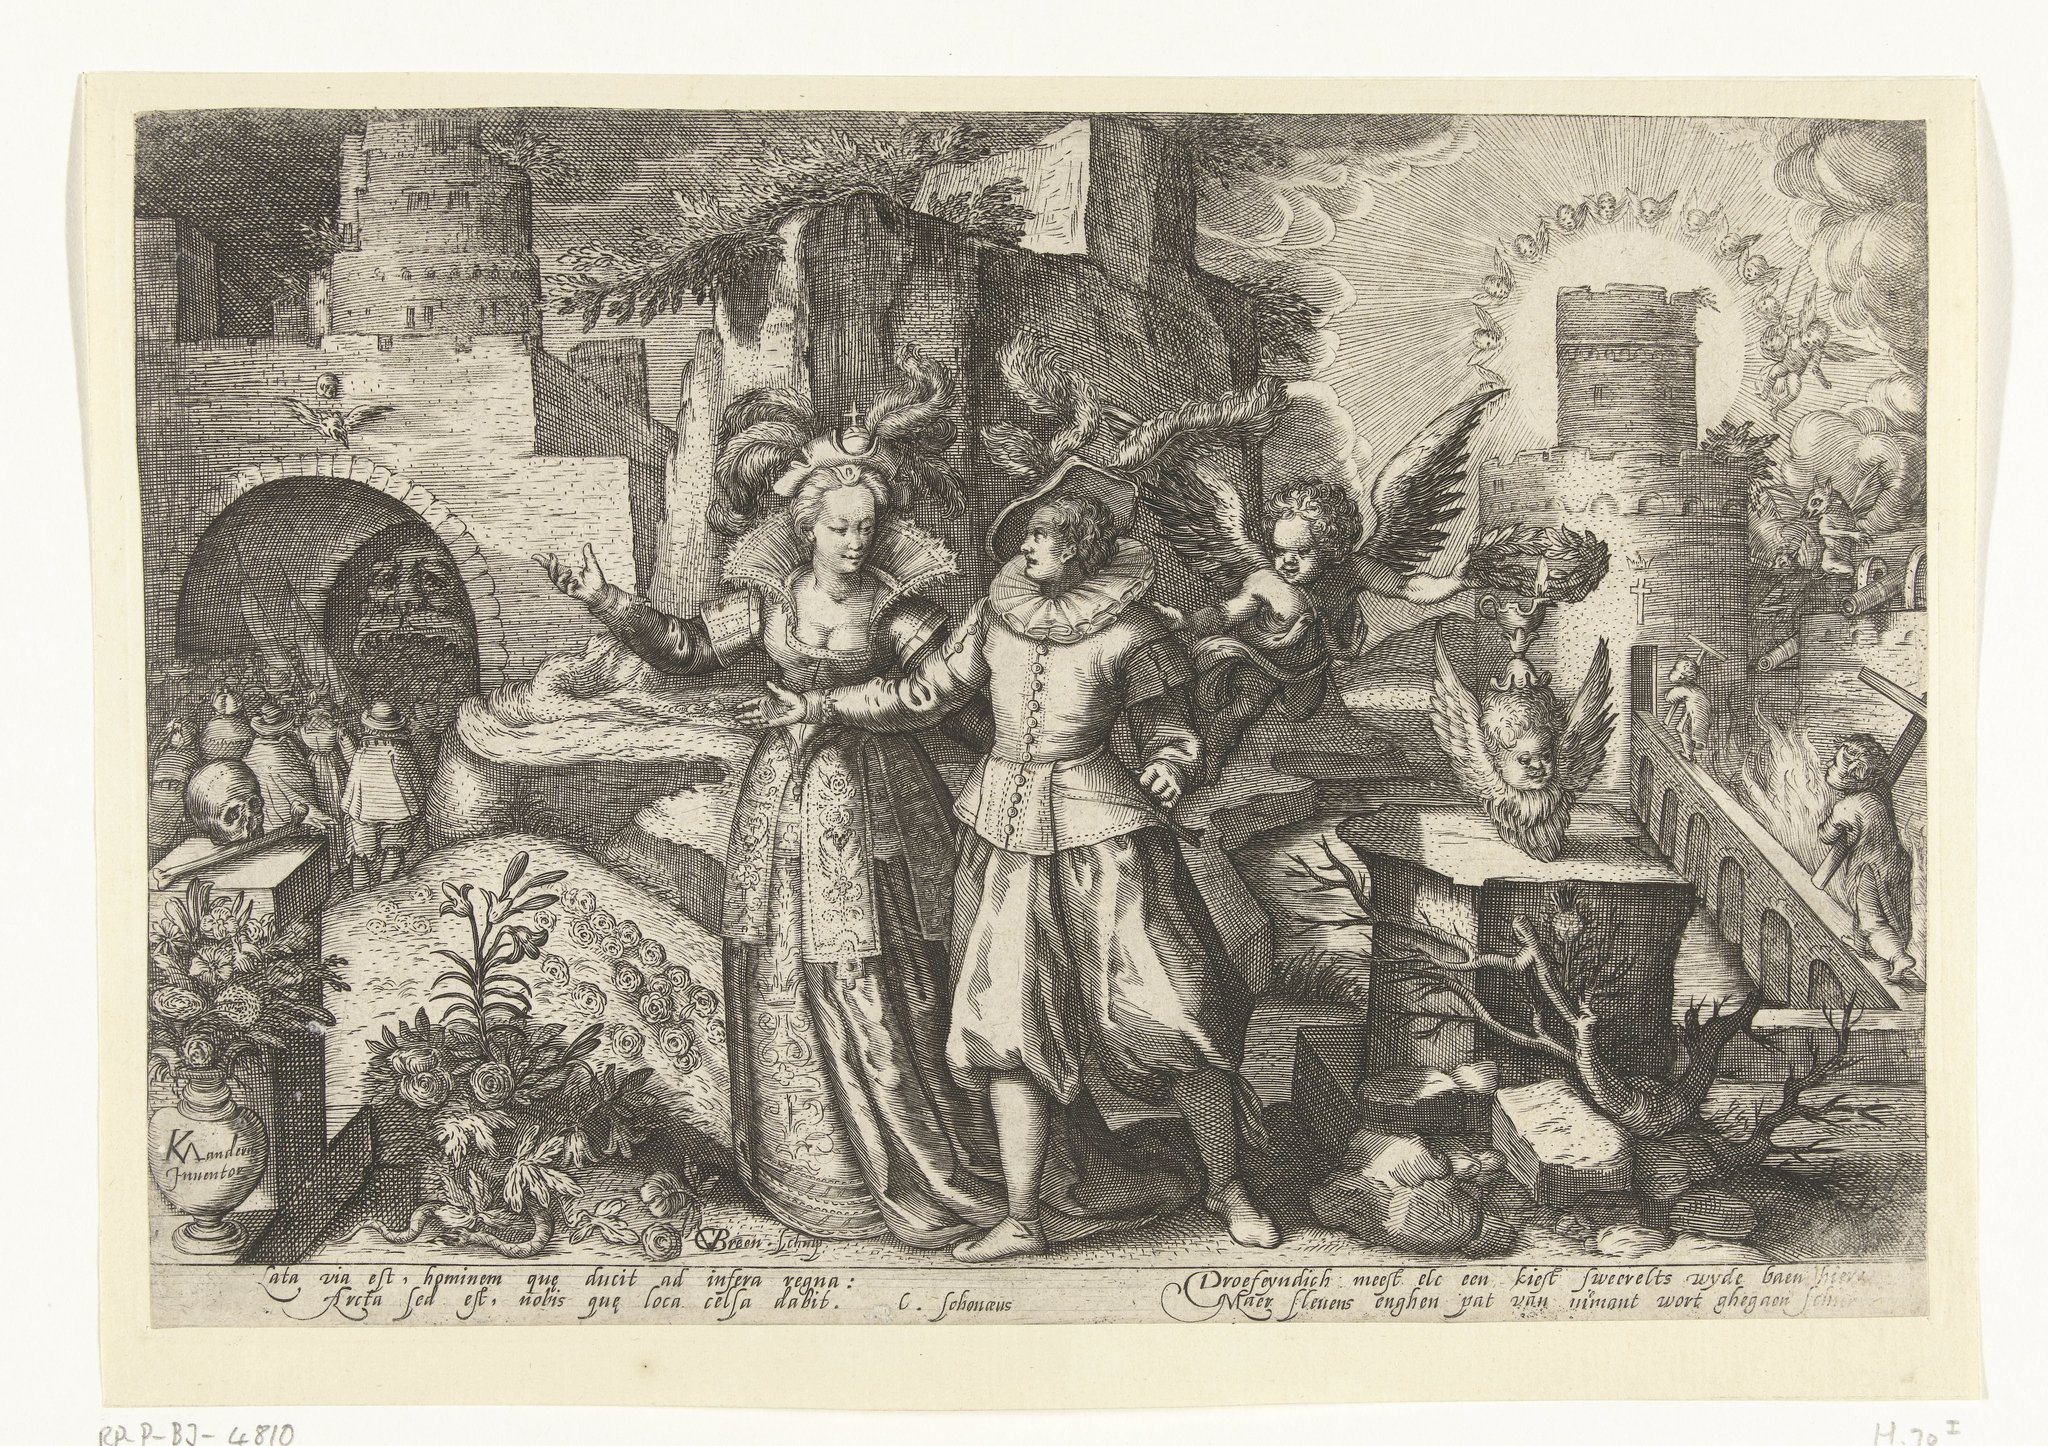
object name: print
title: Allegorie met het brede en smalle pad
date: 1595-1605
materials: paper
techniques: engraving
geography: haarlem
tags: the way to destruction is broad and the gate is wide; the way to life is narrow and the gate is straight ~ doctrine of christ on love, etc. (matthew 7:13-14; luke 13:24)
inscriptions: collector's mark: Lugt 240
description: De personificatie van de Wereld probeert een jongeling te verleiden tot het kiezen van de brede weg, een gemakkelijk pad waar men op rozen loopt, maar die uitkomt in de hellepoort en daarmee de dood. Rechts loopt de smalle en moeizame weg met daarop twee kinderen. Twee mensen balanceren over een smalle brug boven de afgrond. Voor de brug distels en doornen. Ze worden bekogeld door duivels, maar komen uiteindelijk terecht in de hemel. De jongeling neigt naar de brede weg, maar een engel probeert hem over te halen om de overwinningskrans te behalen door het smalle pad te kiezen. Onder de voorstelling een verklarend vers in het Latijn en Nederlands door Cornelis Schonaeus.